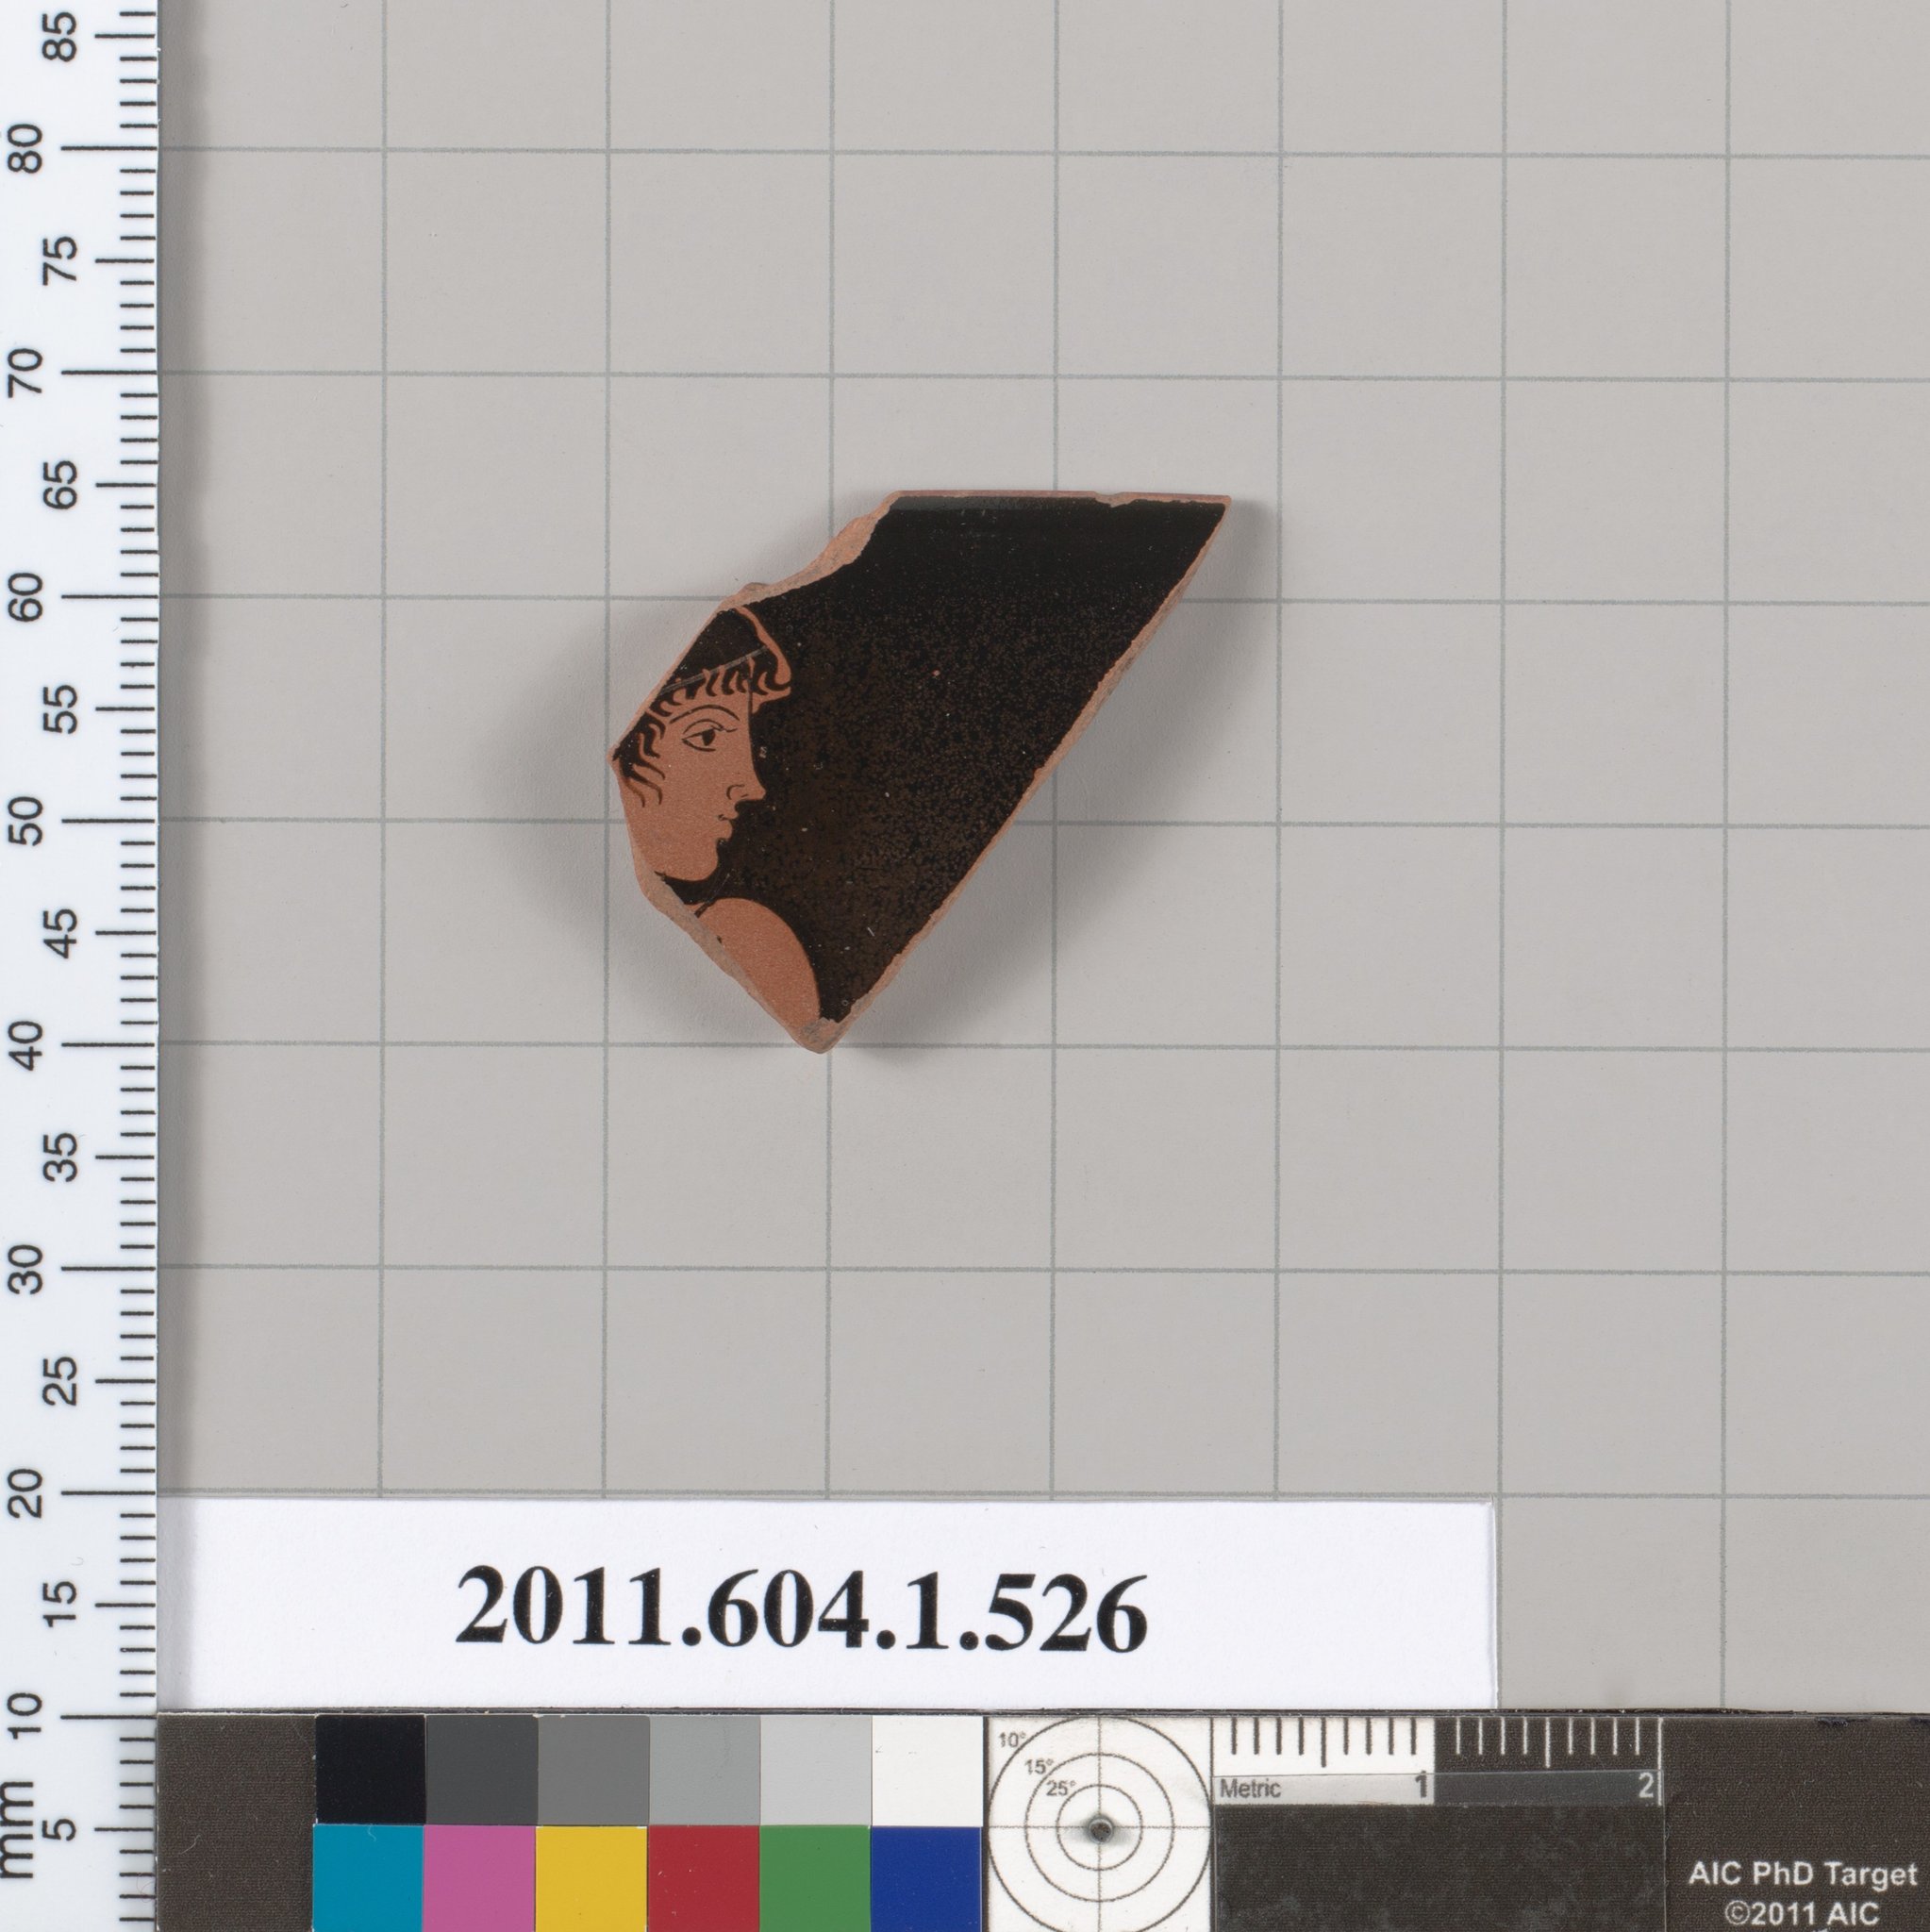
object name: kylix fragment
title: Terracotta rim fragment of a kylix (drinking cup)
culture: greek, attic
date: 480-470 BCE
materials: terracotta